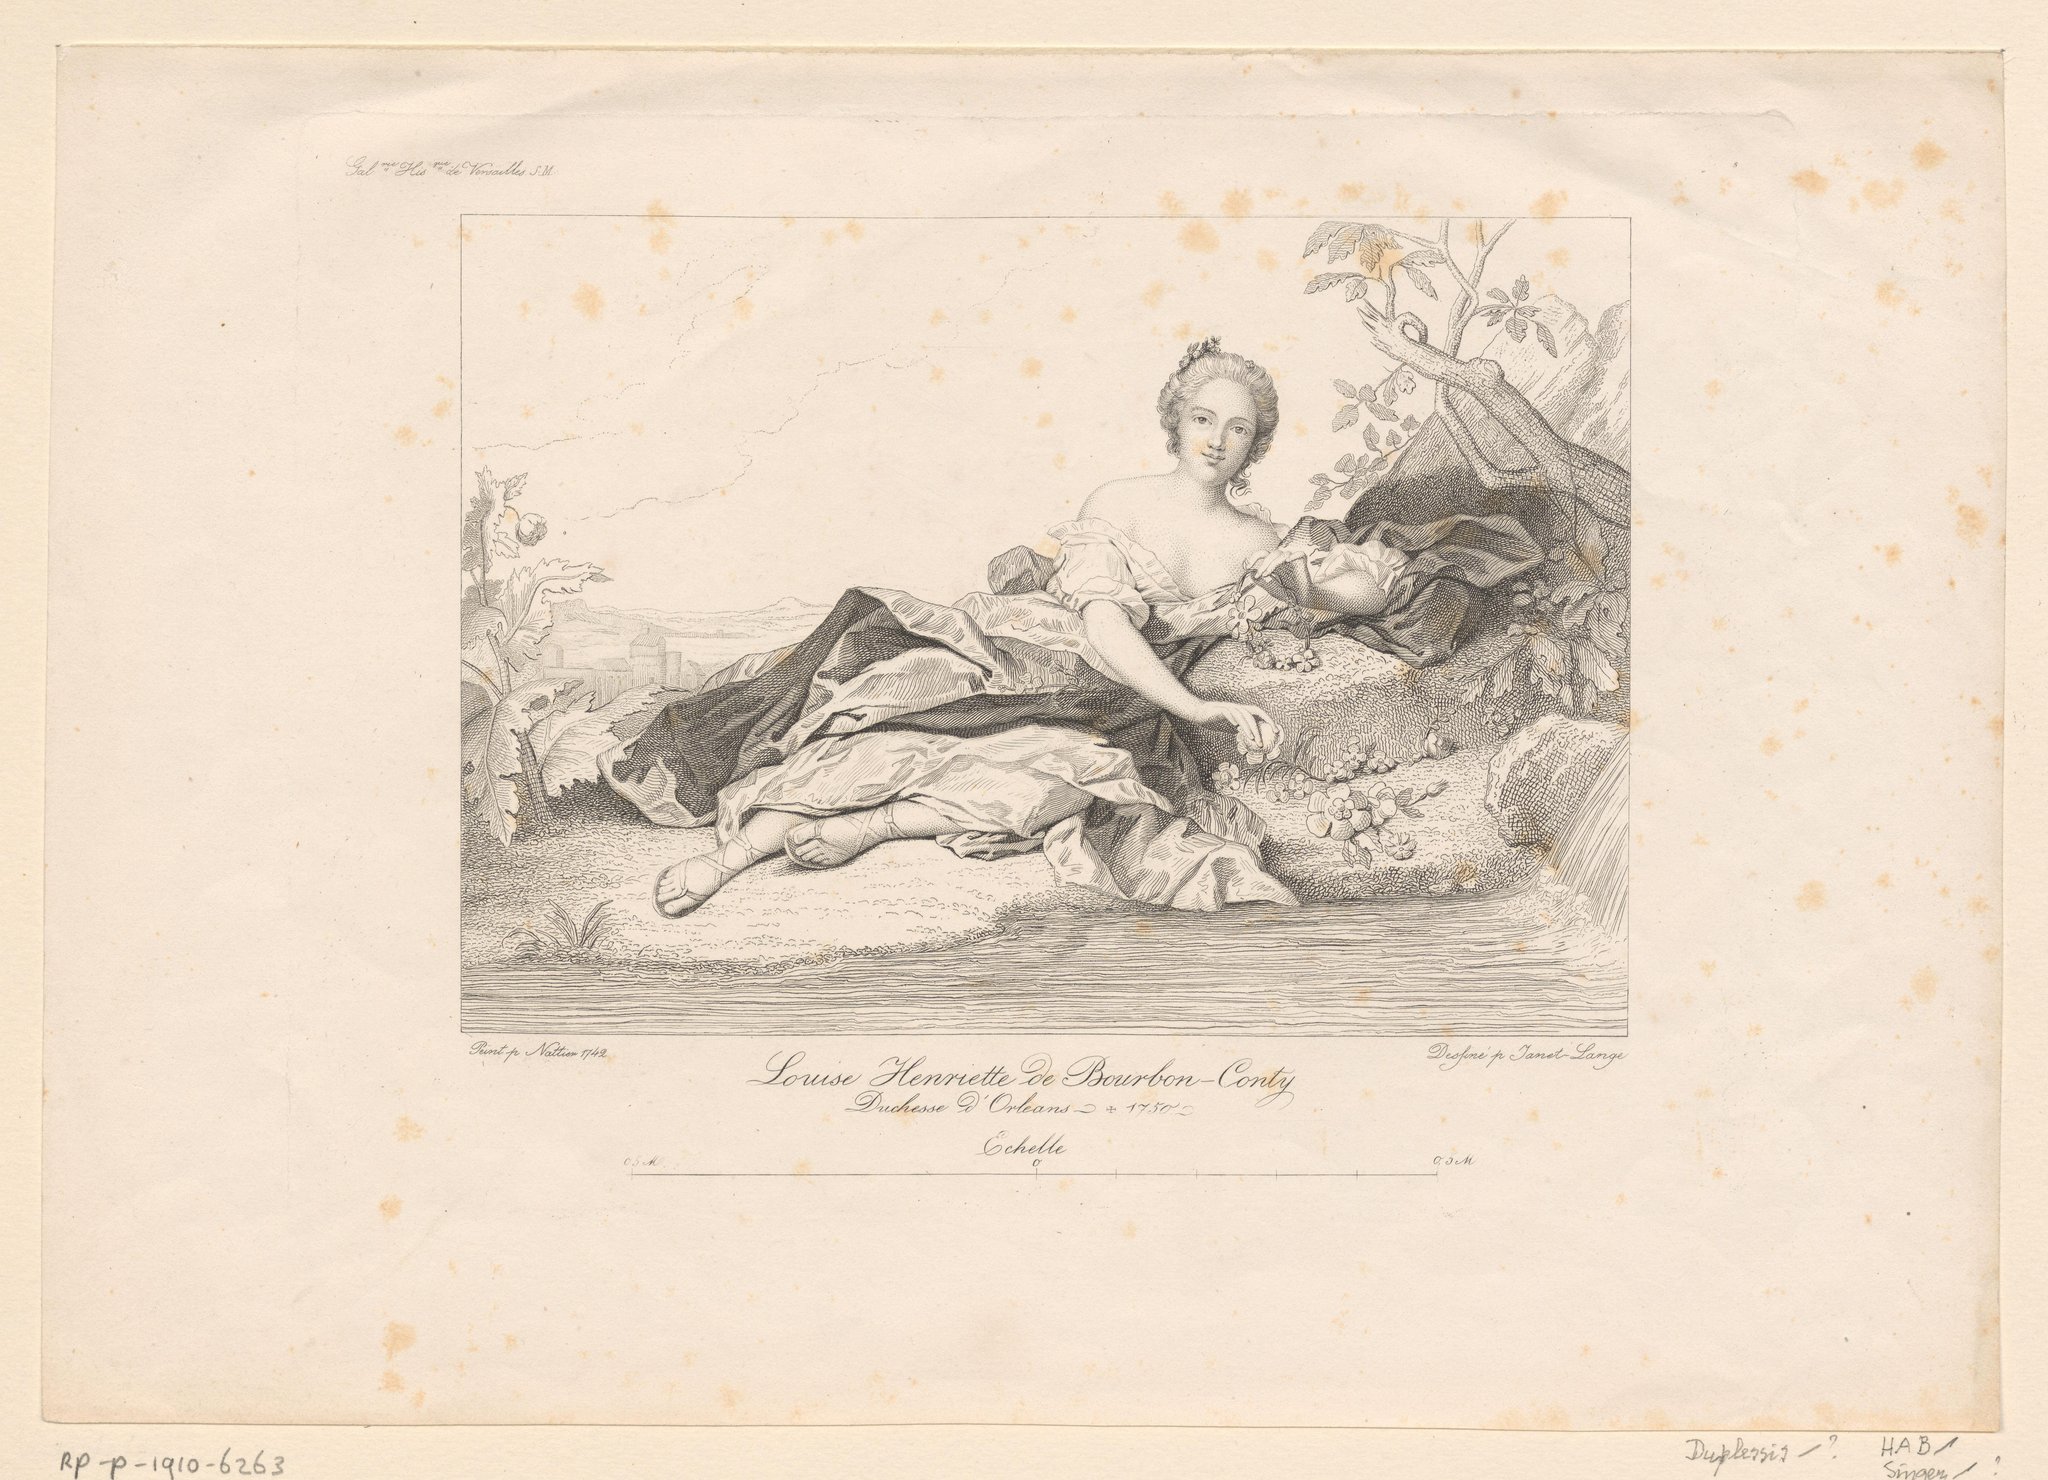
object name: print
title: Galeries historiques de Versailles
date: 1839-1848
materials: paper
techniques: etching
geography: france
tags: paris, historical persons - bb - woman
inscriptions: collector's mark: Lugt 2228